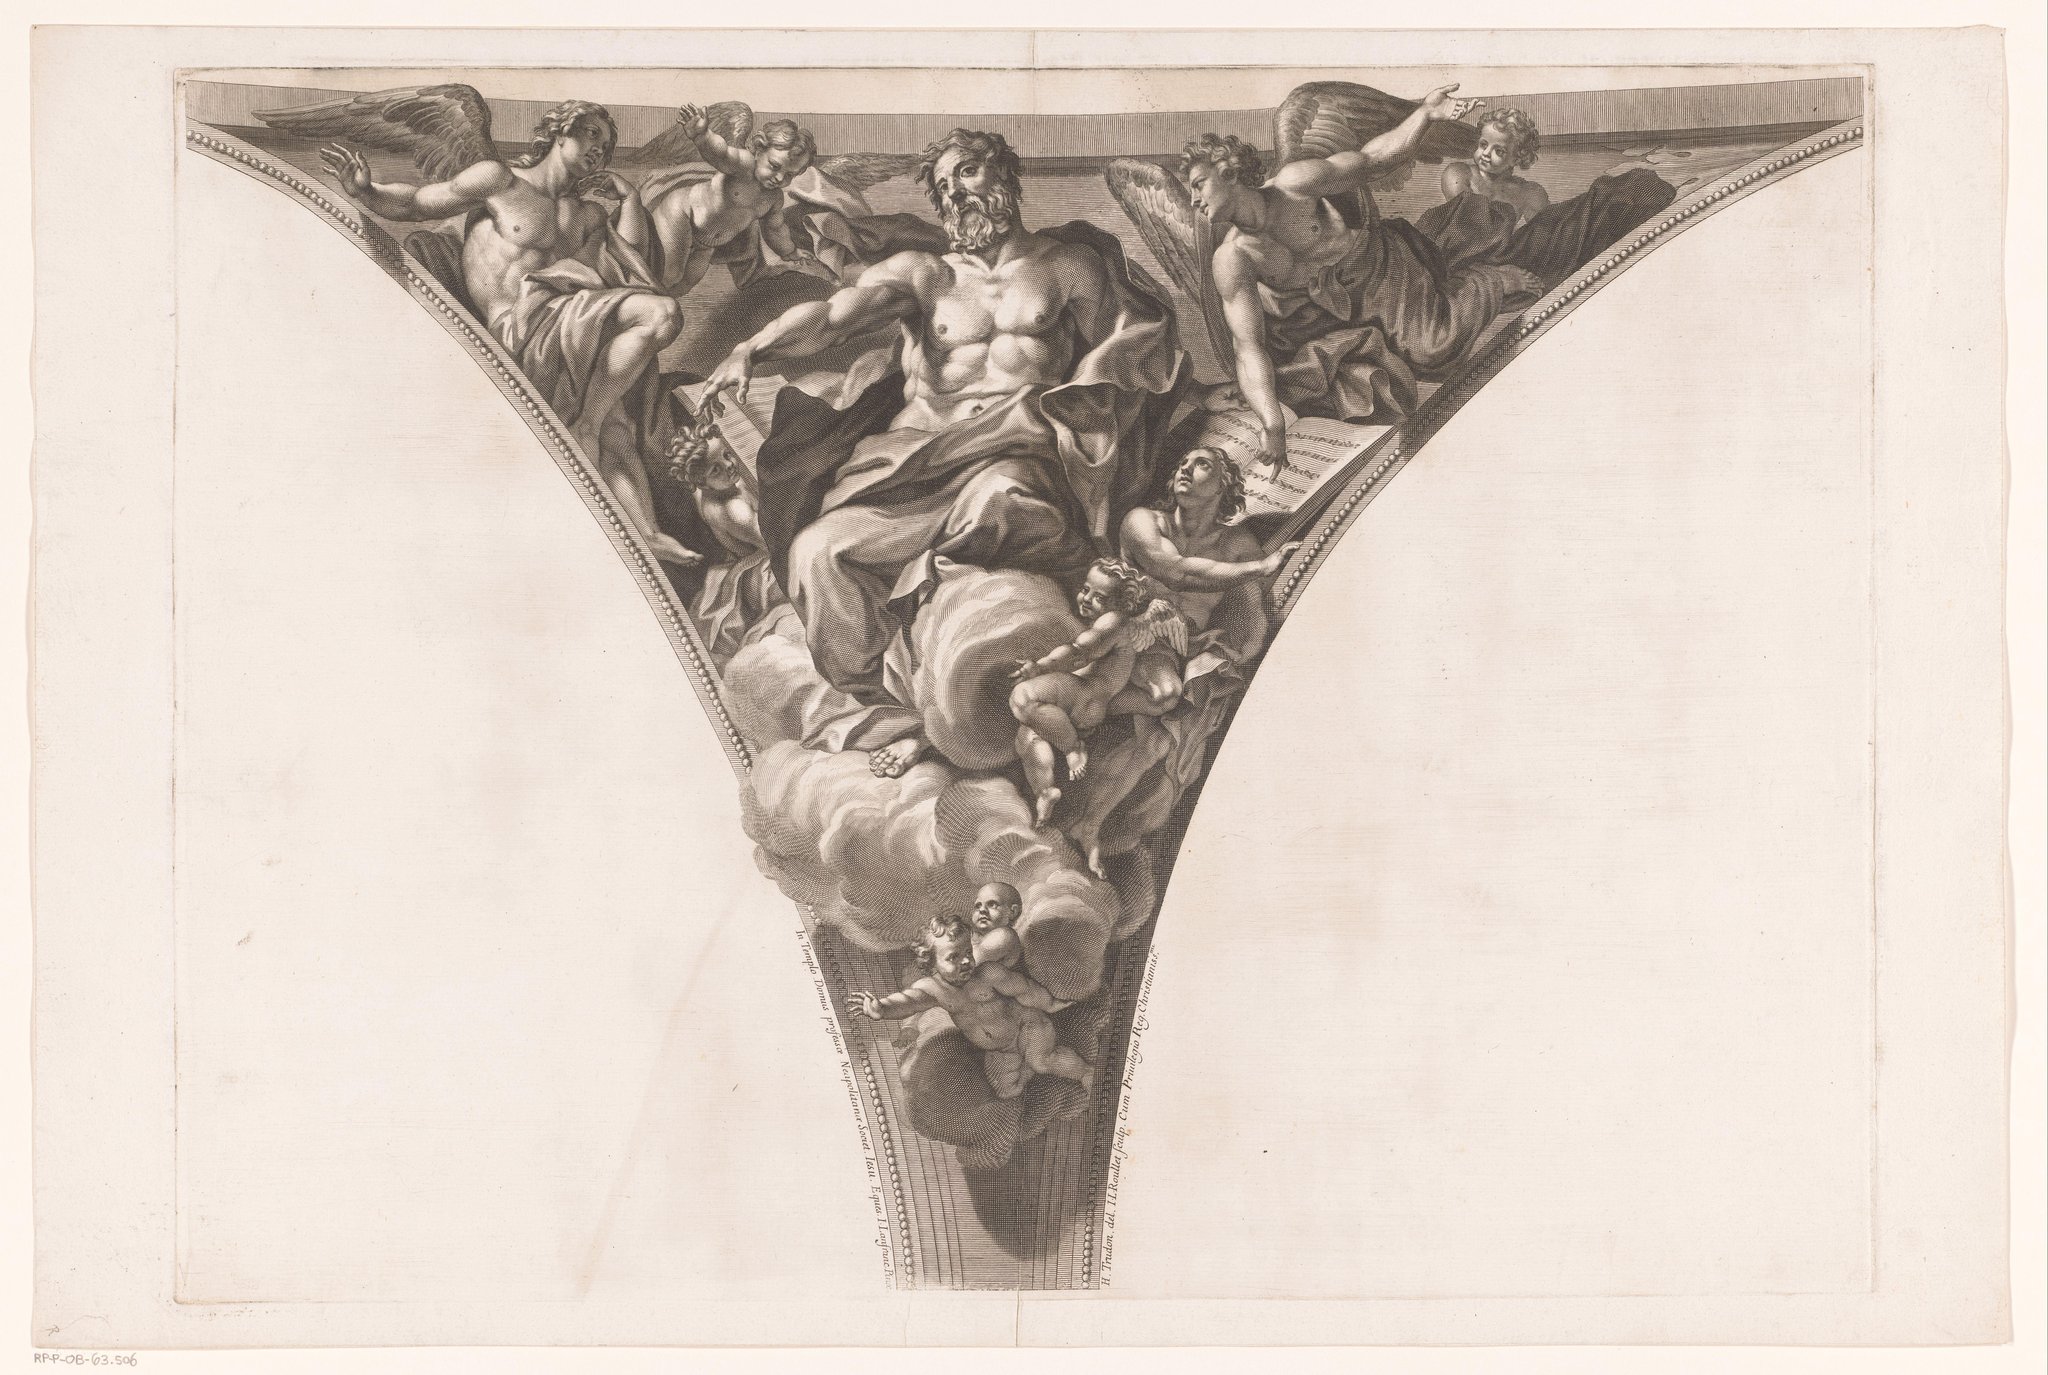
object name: print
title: Evangelist Mattheüs op wolken door engelen omgeven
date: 1655-1699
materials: paper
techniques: engraving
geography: france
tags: the apostle and evangelist matthew (mattheus); possible attributes: angel, axe, book, halberd, pen and inkhorn, purse, scroll, square, sword, angel (possibly with book) ~ symbol of st. matthew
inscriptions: collector's mark: Lugt 240